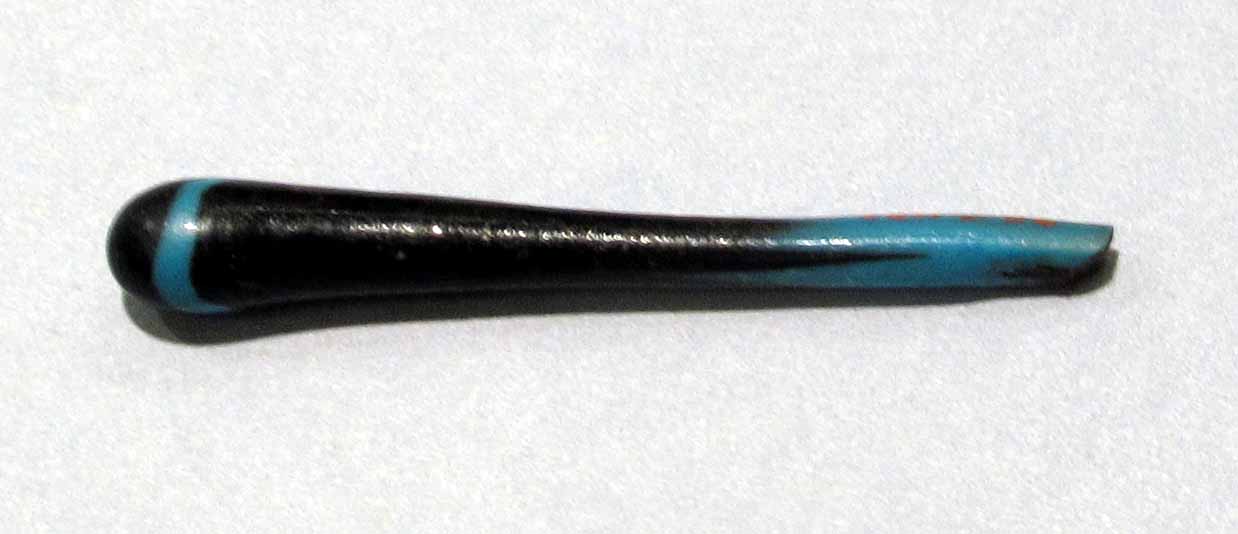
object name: kohl stick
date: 1550-1295 BCE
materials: glass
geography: egypt